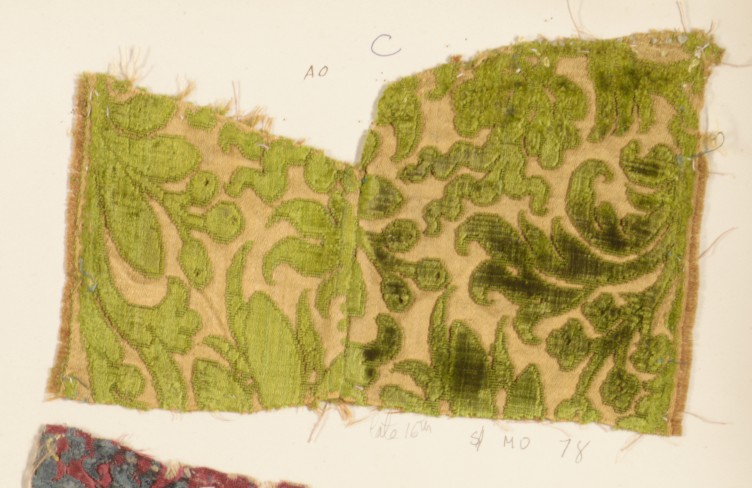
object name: fragment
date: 1567-1600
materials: silk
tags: leaves